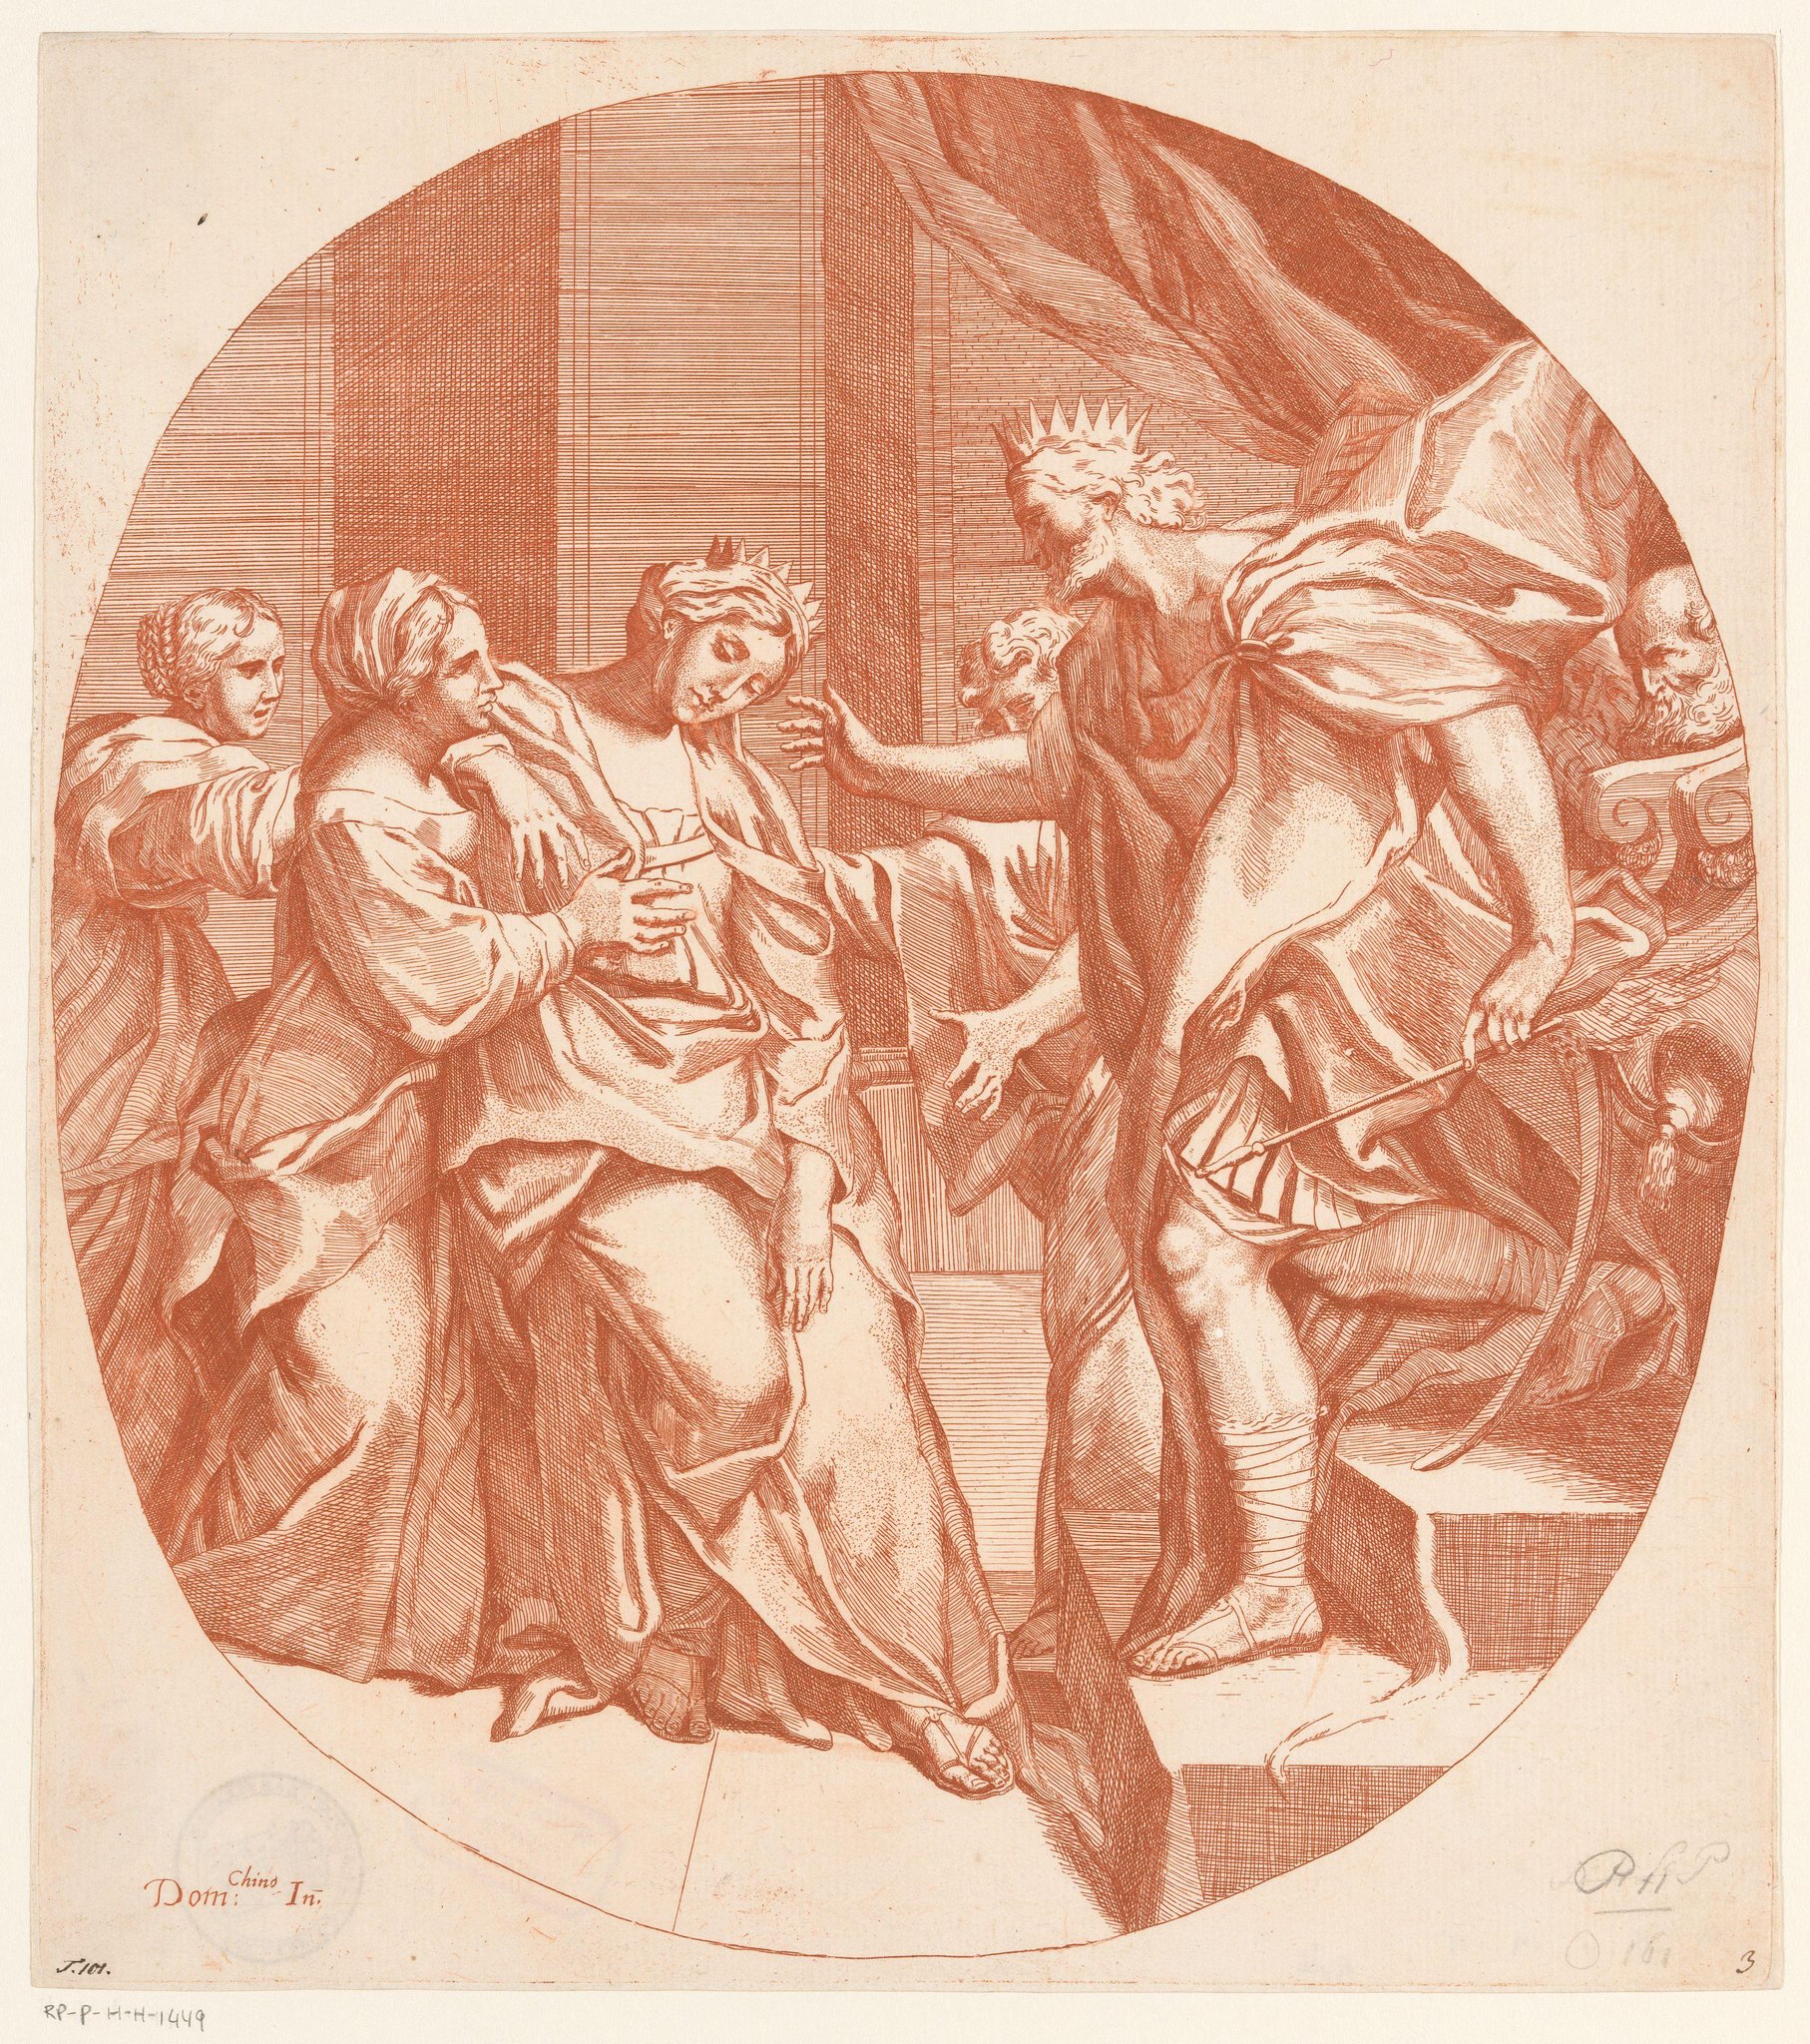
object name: print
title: Voorstellingen uit het Oude Testament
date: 1591-1691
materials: paper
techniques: etching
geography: italy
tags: ahasuerus leaps from his throne and takes esther in his arms (esther 15:8), esther swoons on the shoulder of one of her maids (esther 15:7)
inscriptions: collector's mark: Lugt 10, number: ‘3’, inscription: ‘T. 101.’, collector's mark: Lugt 11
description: Esther staat voor de troon van koning Ahasveros en leunt op de schouder van een van haar dienstmaagden. De koning stapt van zijn troon om haar te ontvangen.